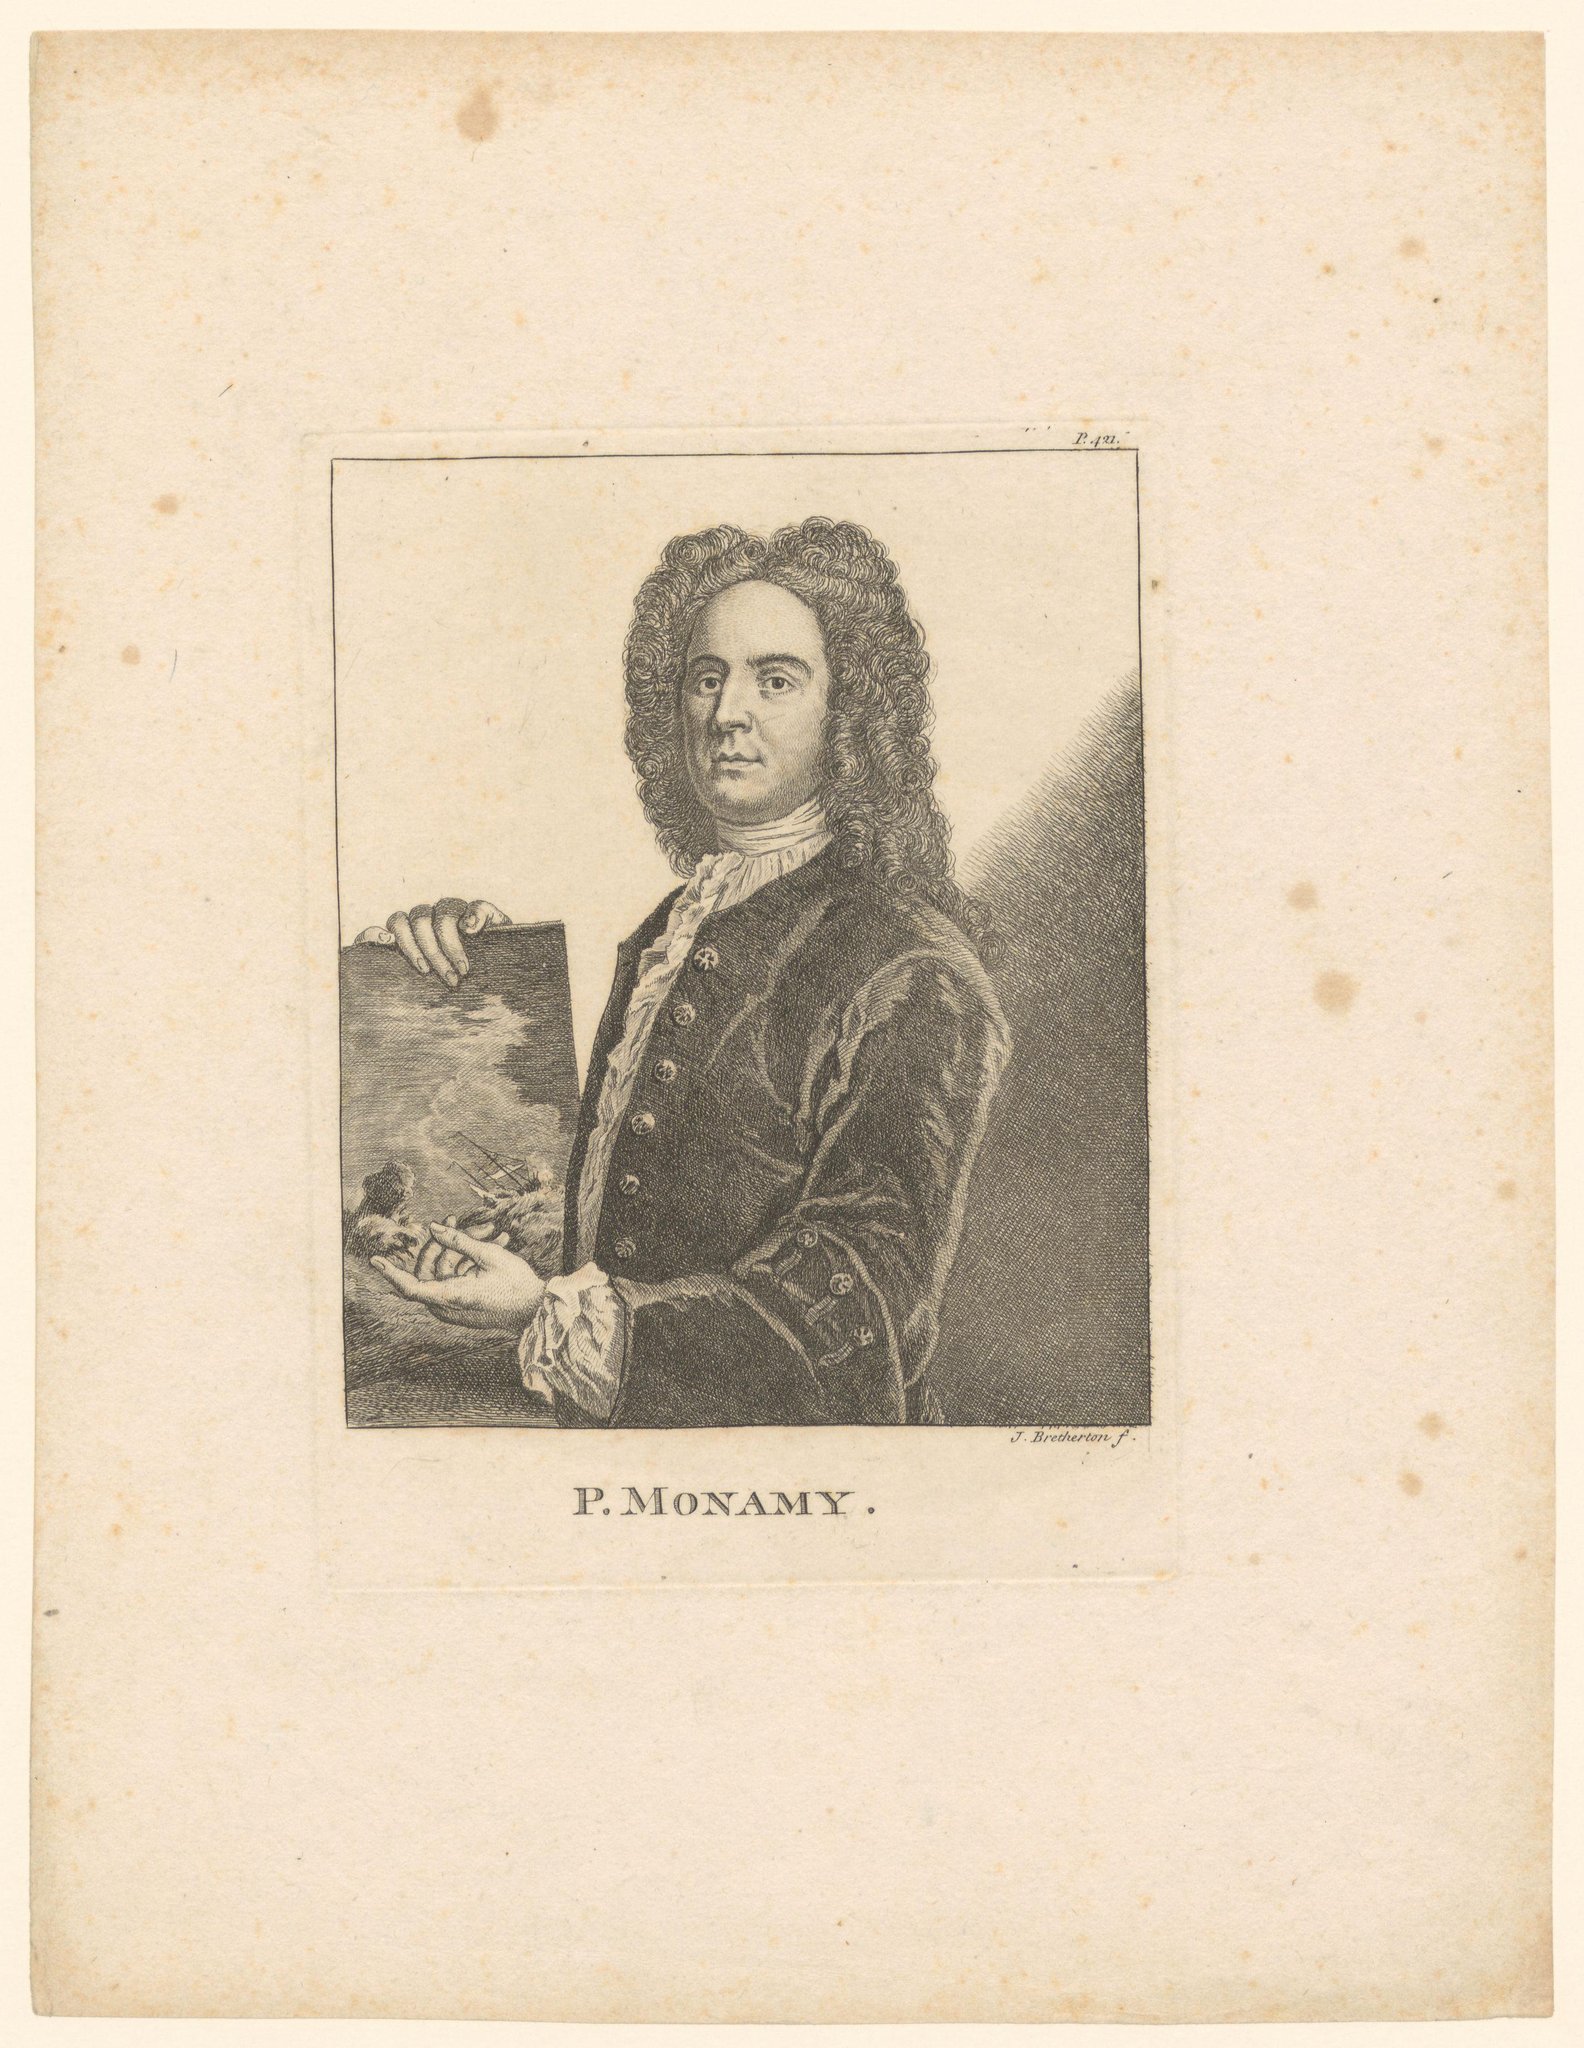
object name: print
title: P. Monamy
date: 1762-1771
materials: paper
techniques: etching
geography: strawberry hill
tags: london, painter, peter monamy, historical persons, portrait, self-portrait of painter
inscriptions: collector's mark: Lugt 2228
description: Prent uit: Walpole, Horace, en George Vertue. Anecdotes of Painting in England (...). Strawberry Hill: Horace Walpole, 1762-1771, p. 421.